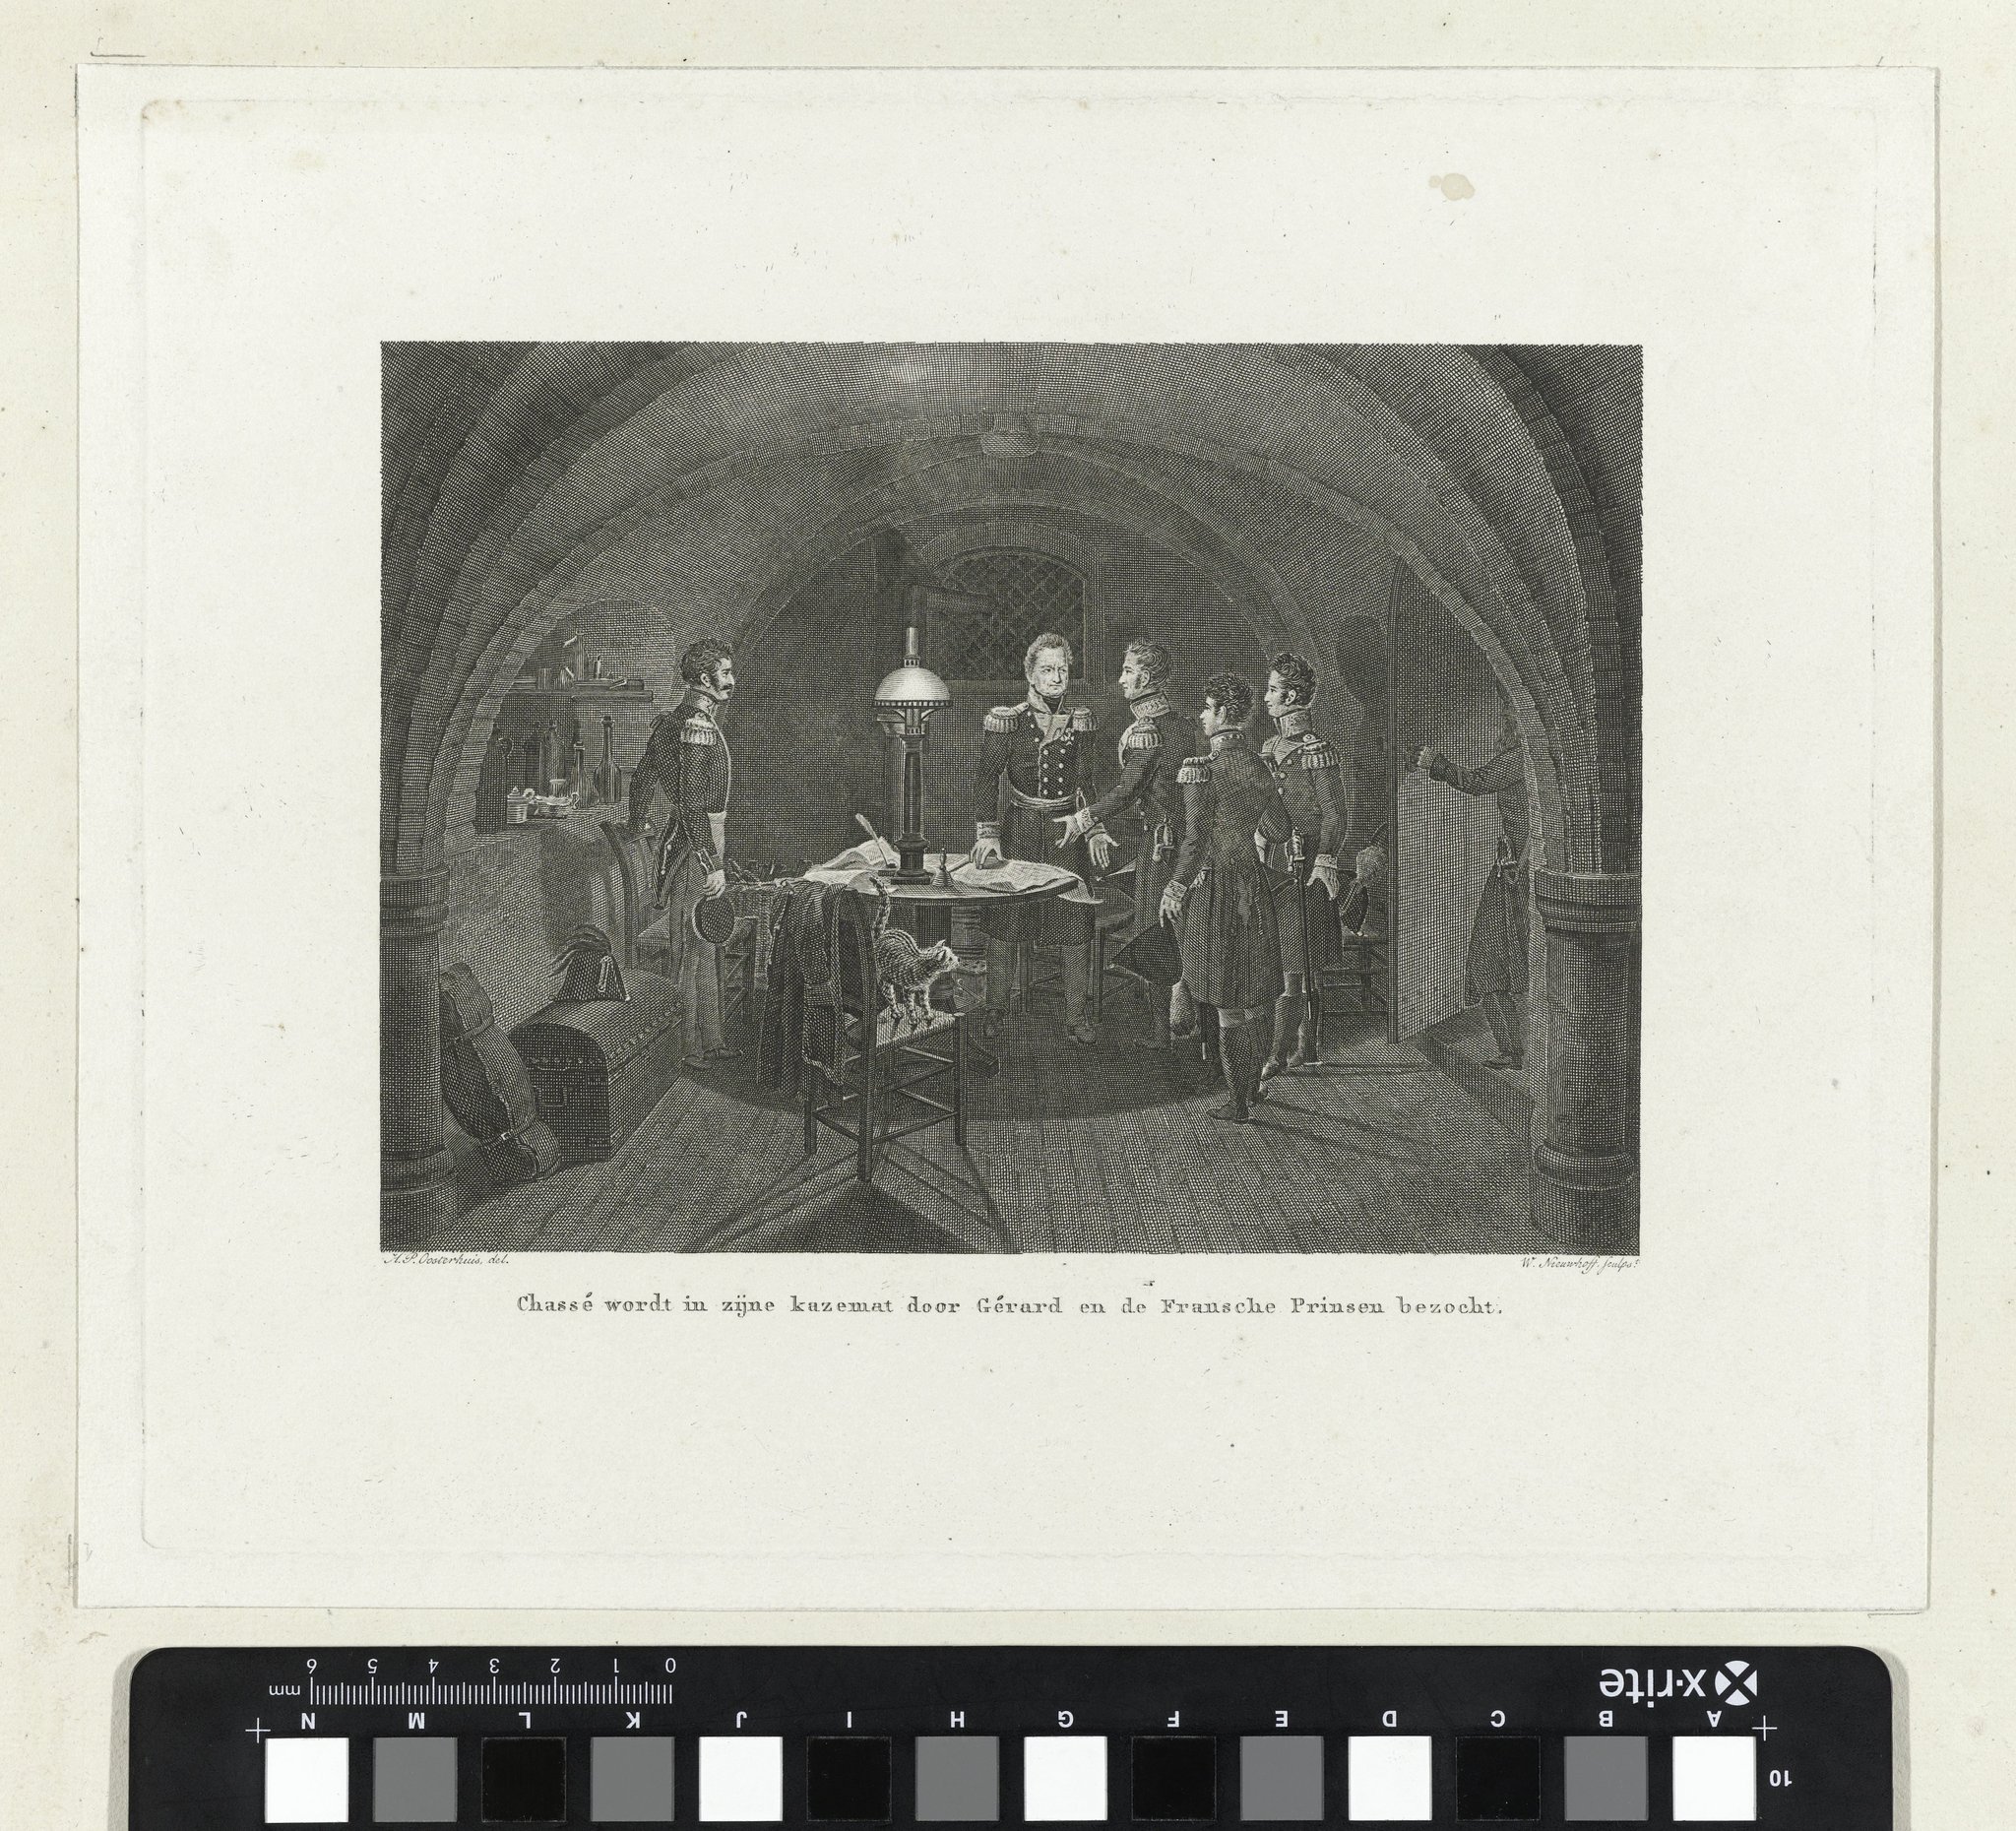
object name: print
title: Generaal Gérard bezoekt generaal Chassé in de Citadel van Antwerpen, 1832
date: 1833-1834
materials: paper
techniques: engraving, etching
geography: netherlands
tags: david hendrik baron chassé, capitulation, capture of city (after the siege), permanent fortifications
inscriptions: collector's mark: Lugt 2228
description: Gebruikt als illustratie in: Nicolaas Godfried van Kampen, Gedenkboek van Nederlands moed en trouw, gedurende den Belgischen opstand. Haarlem : Bohn, 1834.